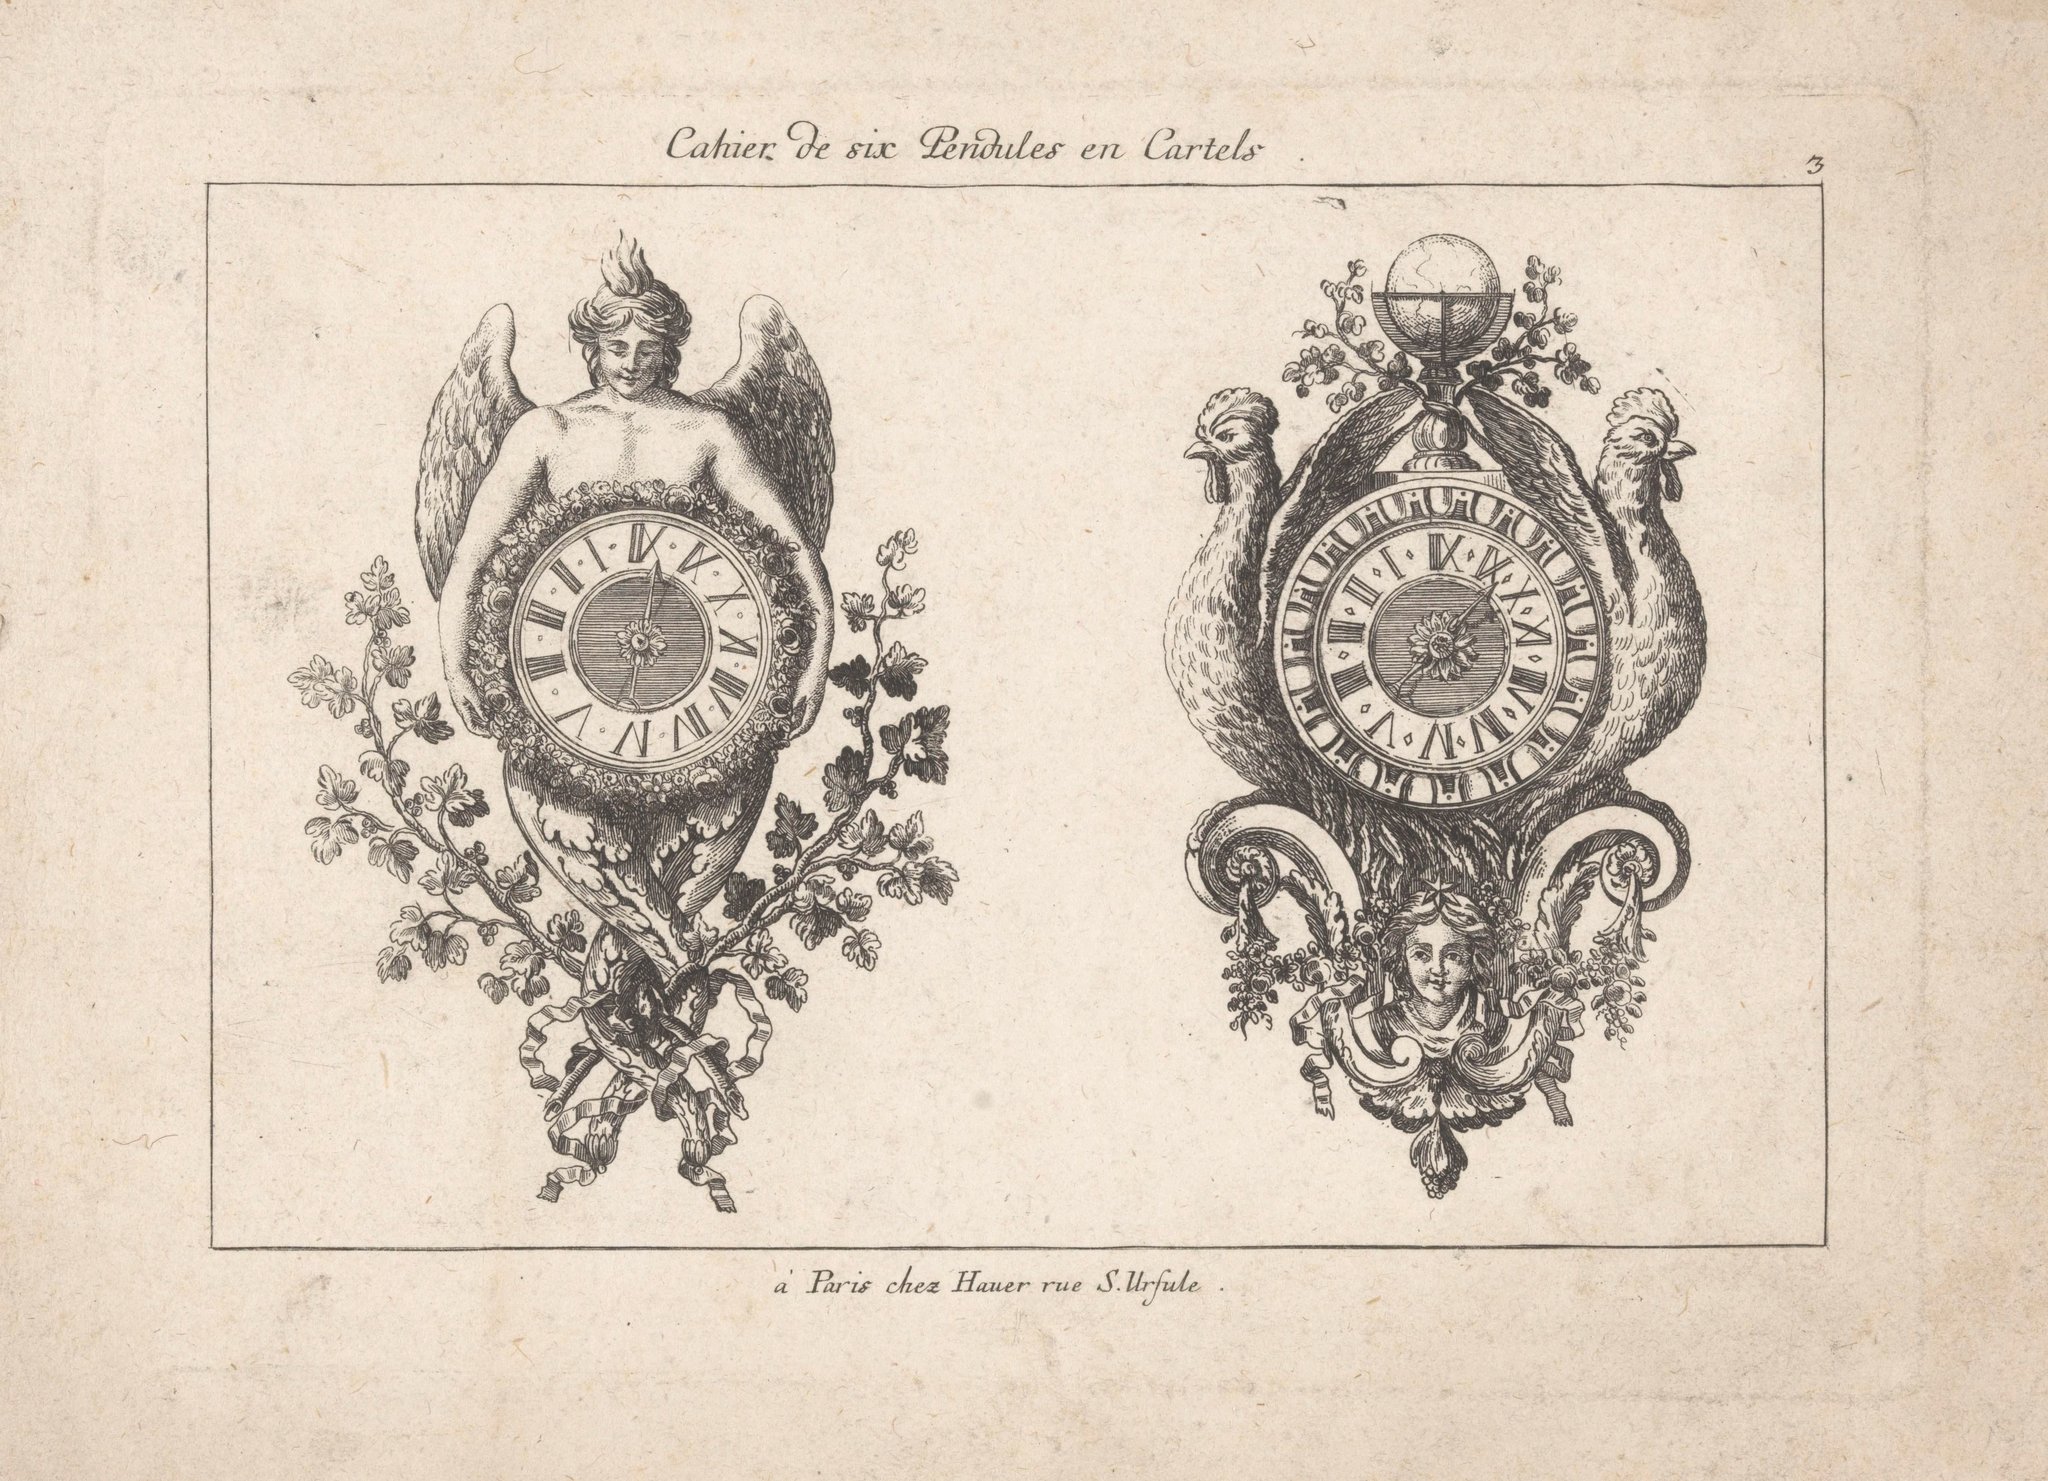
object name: print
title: Twee cartelklokken met gevleugelde figuur en kippen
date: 1758-1820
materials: paper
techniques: etching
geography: paris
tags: clock, fowl (cock, hen, chicken, etc.), fabulous beings with wings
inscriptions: collector's mark: Lugt 2228, collector's mark: Lugt 2760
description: Ontwerpen voor twee cartelklokken. De klok links wordt gedragen door een gevleugelde figuur wiens benen in bladeren overlopen. Twee kippen flankeren de rechterklok.